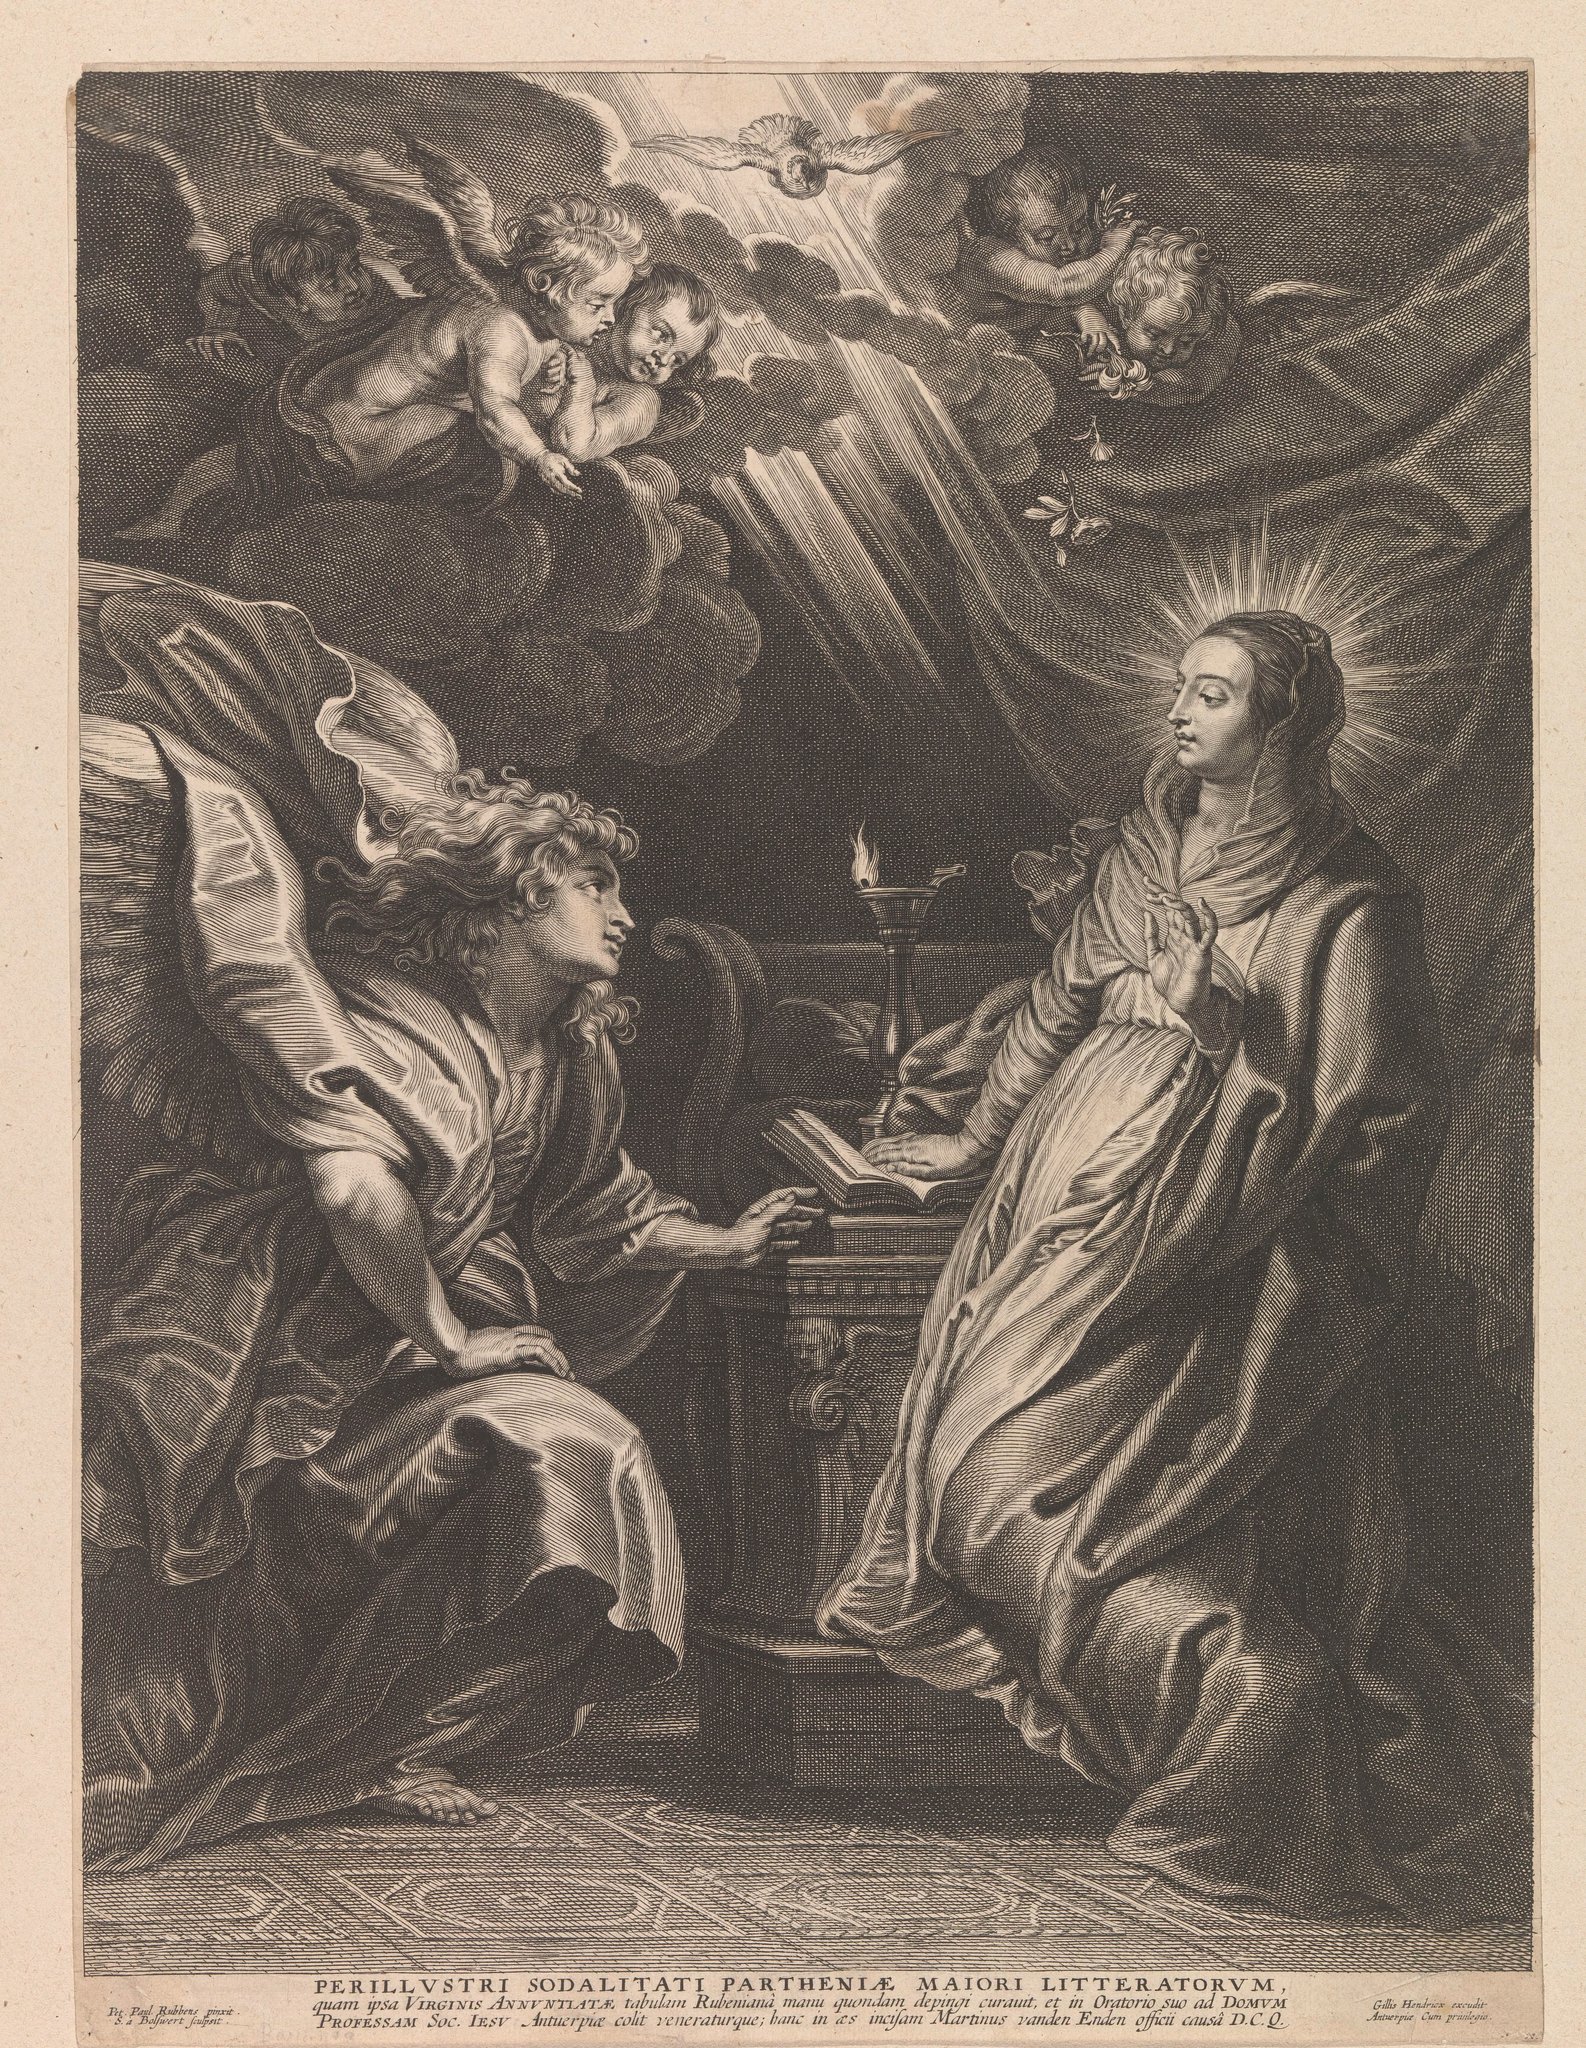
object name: album leaf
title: Annunciatie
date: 1596-1659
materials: paper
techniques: engraving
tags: the annunciation: mary, usually reading, is visited by the angel (sometimes a woman overhears the conversation)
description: Annunciatie (los blad). Deze prent maakt deel uit van een album.